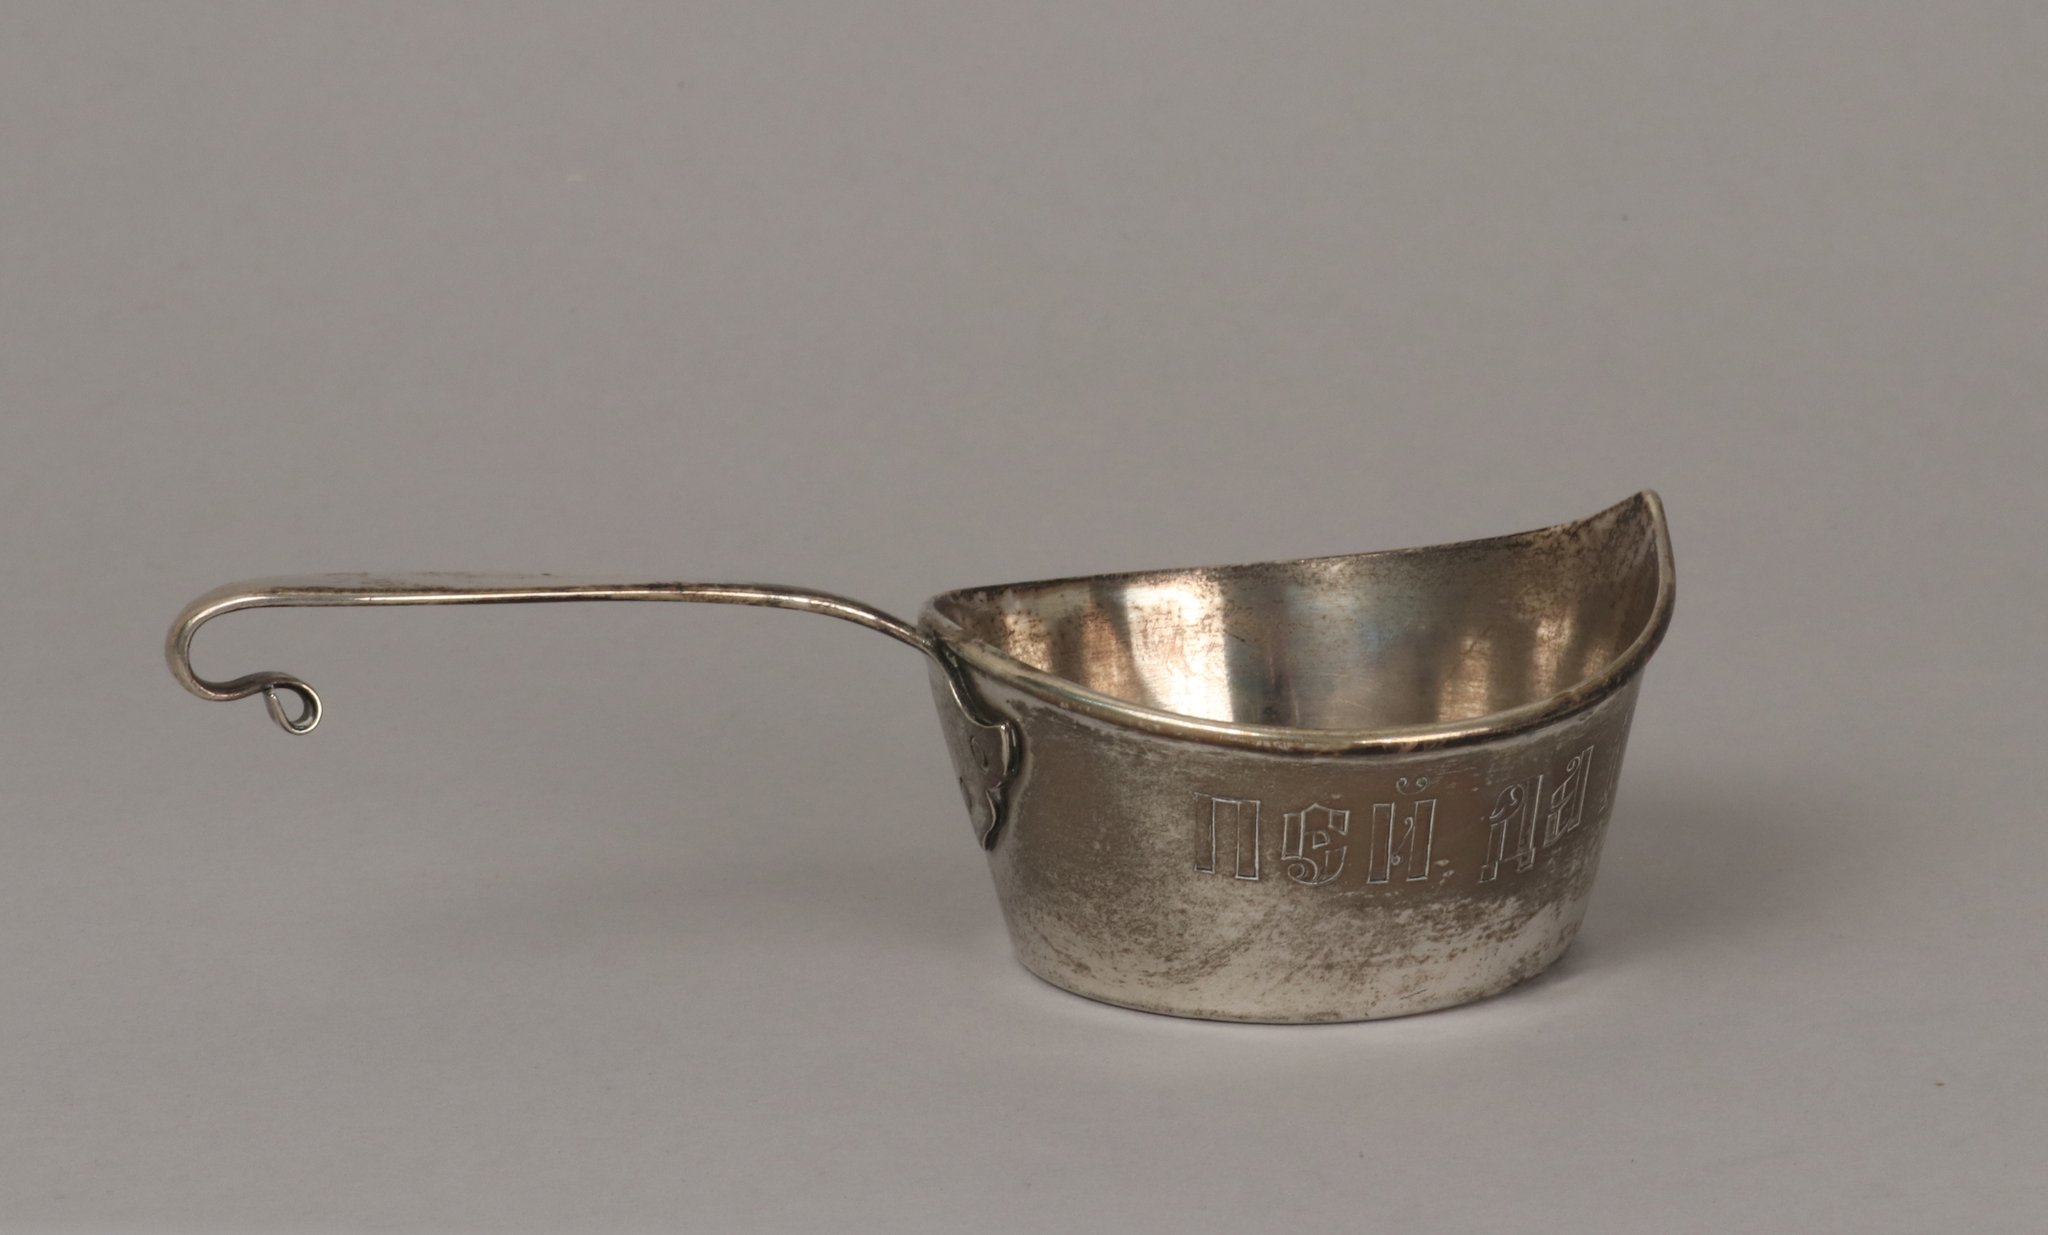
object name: dipper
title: Dipper (Loving cup)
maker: alan berg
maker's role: maker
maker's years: 1825-1925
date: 1874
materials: silver